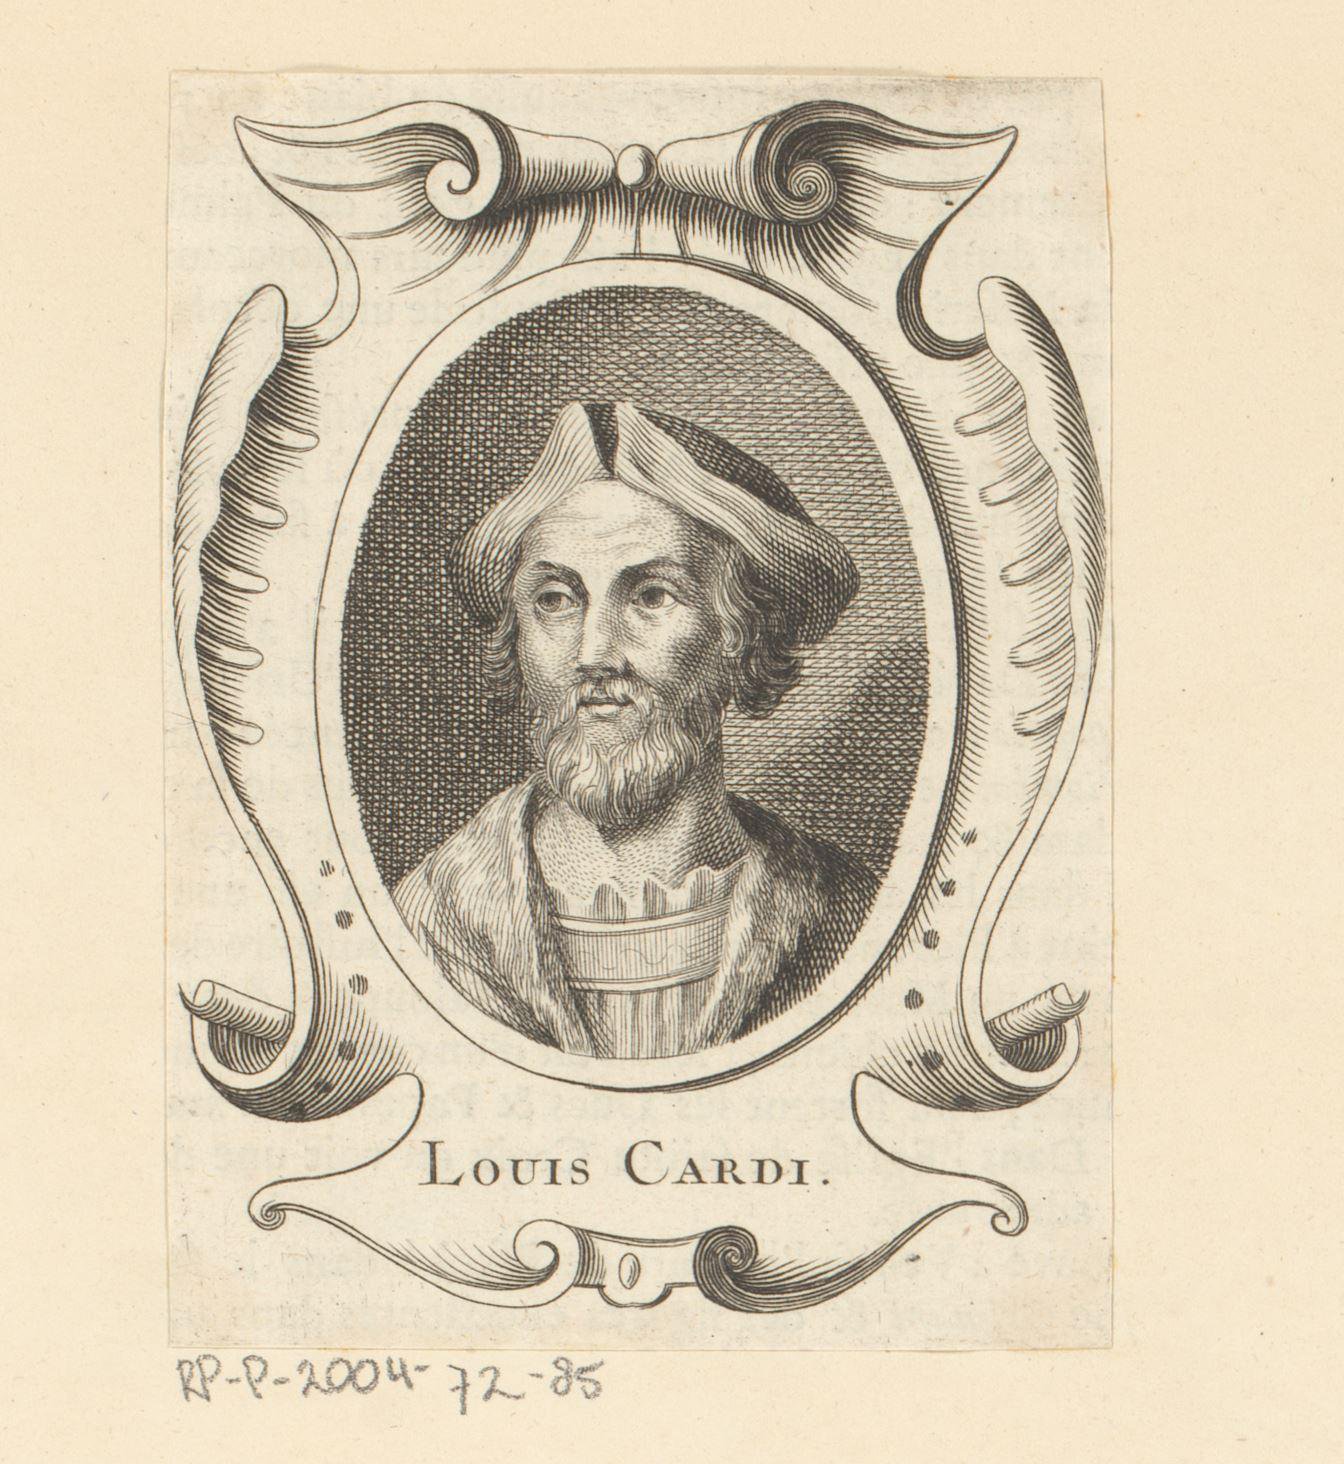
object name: print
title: Portret van Lodovico Cardi, ook bekend als Cigoli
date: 1745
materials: paper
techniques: engraving, letterpress printing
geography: paris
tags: rome, draughtsman, cigoli, historical persons, portrait, self-portrait of painter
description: Prent uit: Dézallier d'Argenville, Antoine Joseph. Abrégé de la vie des plus fameux peintres. 4 dln. Parijs: De Bure l'aîné, 1745, dl. 1, p. 116. De samensteller heeft deze prent in het album geplakt als illustratie bij: Pilkington, Matthew en Johann Heinrich Füssli. A dictionary of painters, from the revival of the art to the present period. 4 dln. Londen: John Crowder, 1805, dl. 1, p. 107.